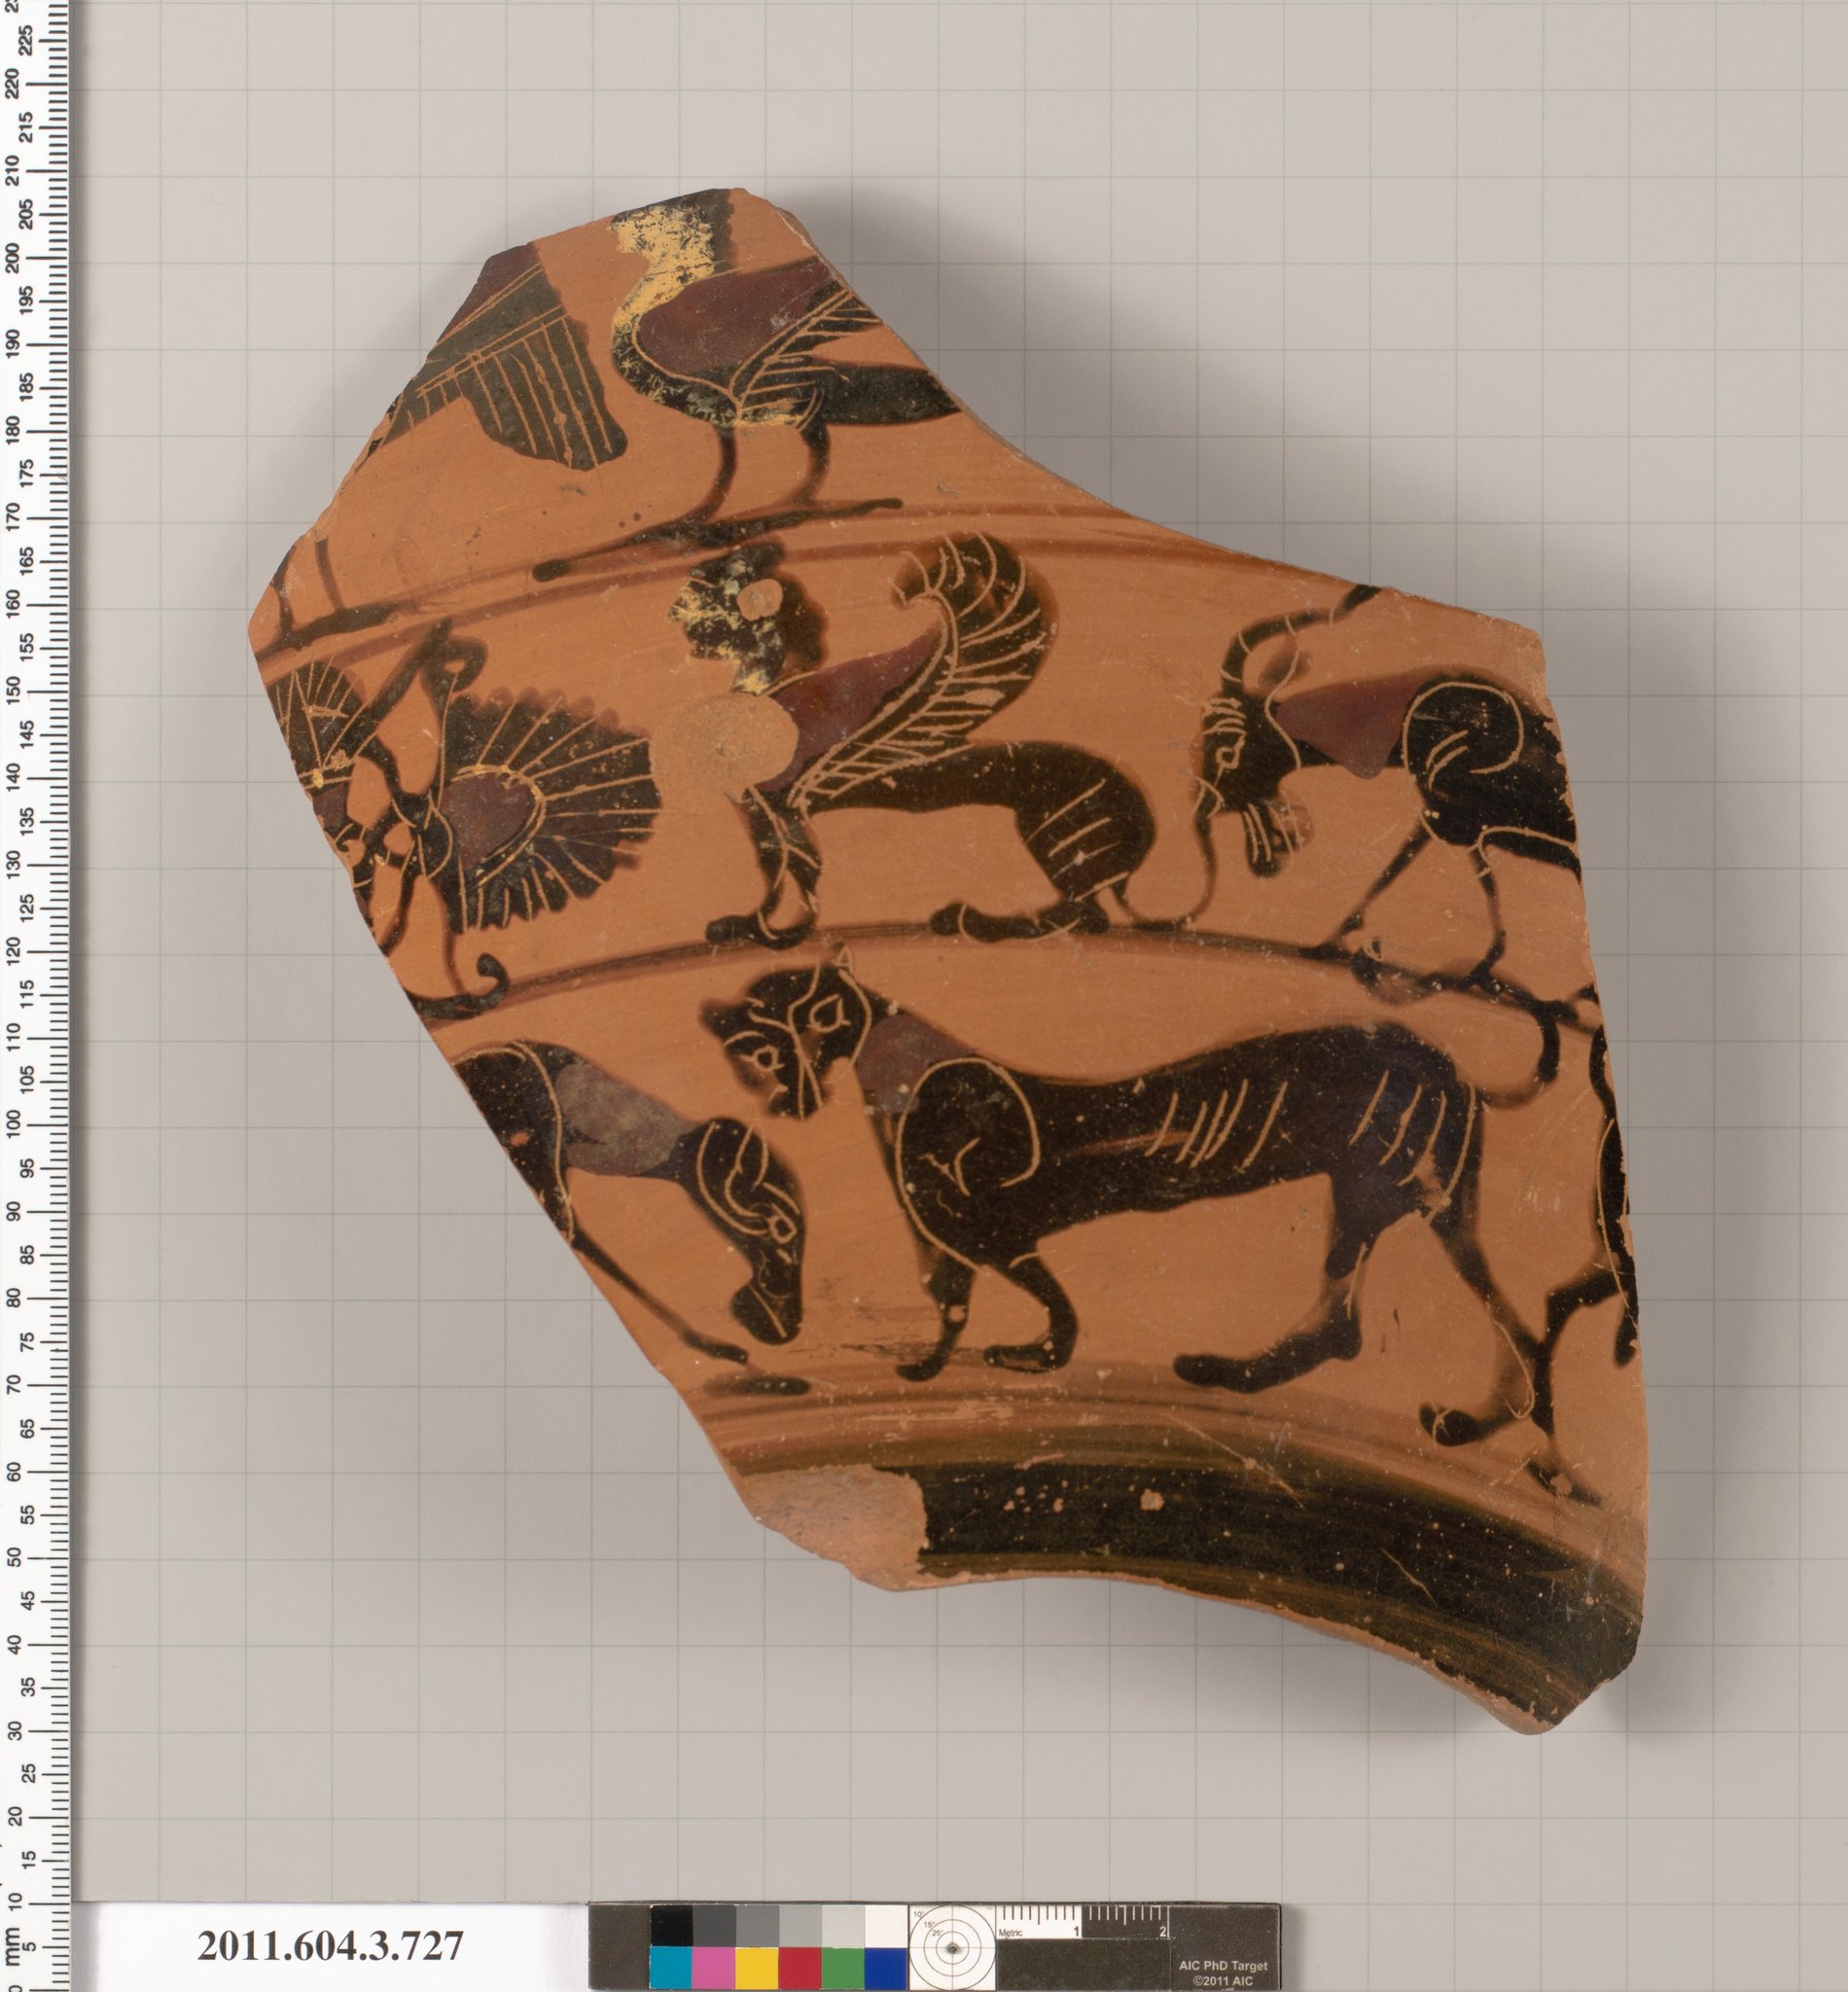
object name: neck amphora, tyrrhenian fragment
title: Terracotta fragment of a neck-amphora (jar)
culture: greek, attic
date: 575-551 BCE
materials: terracotta